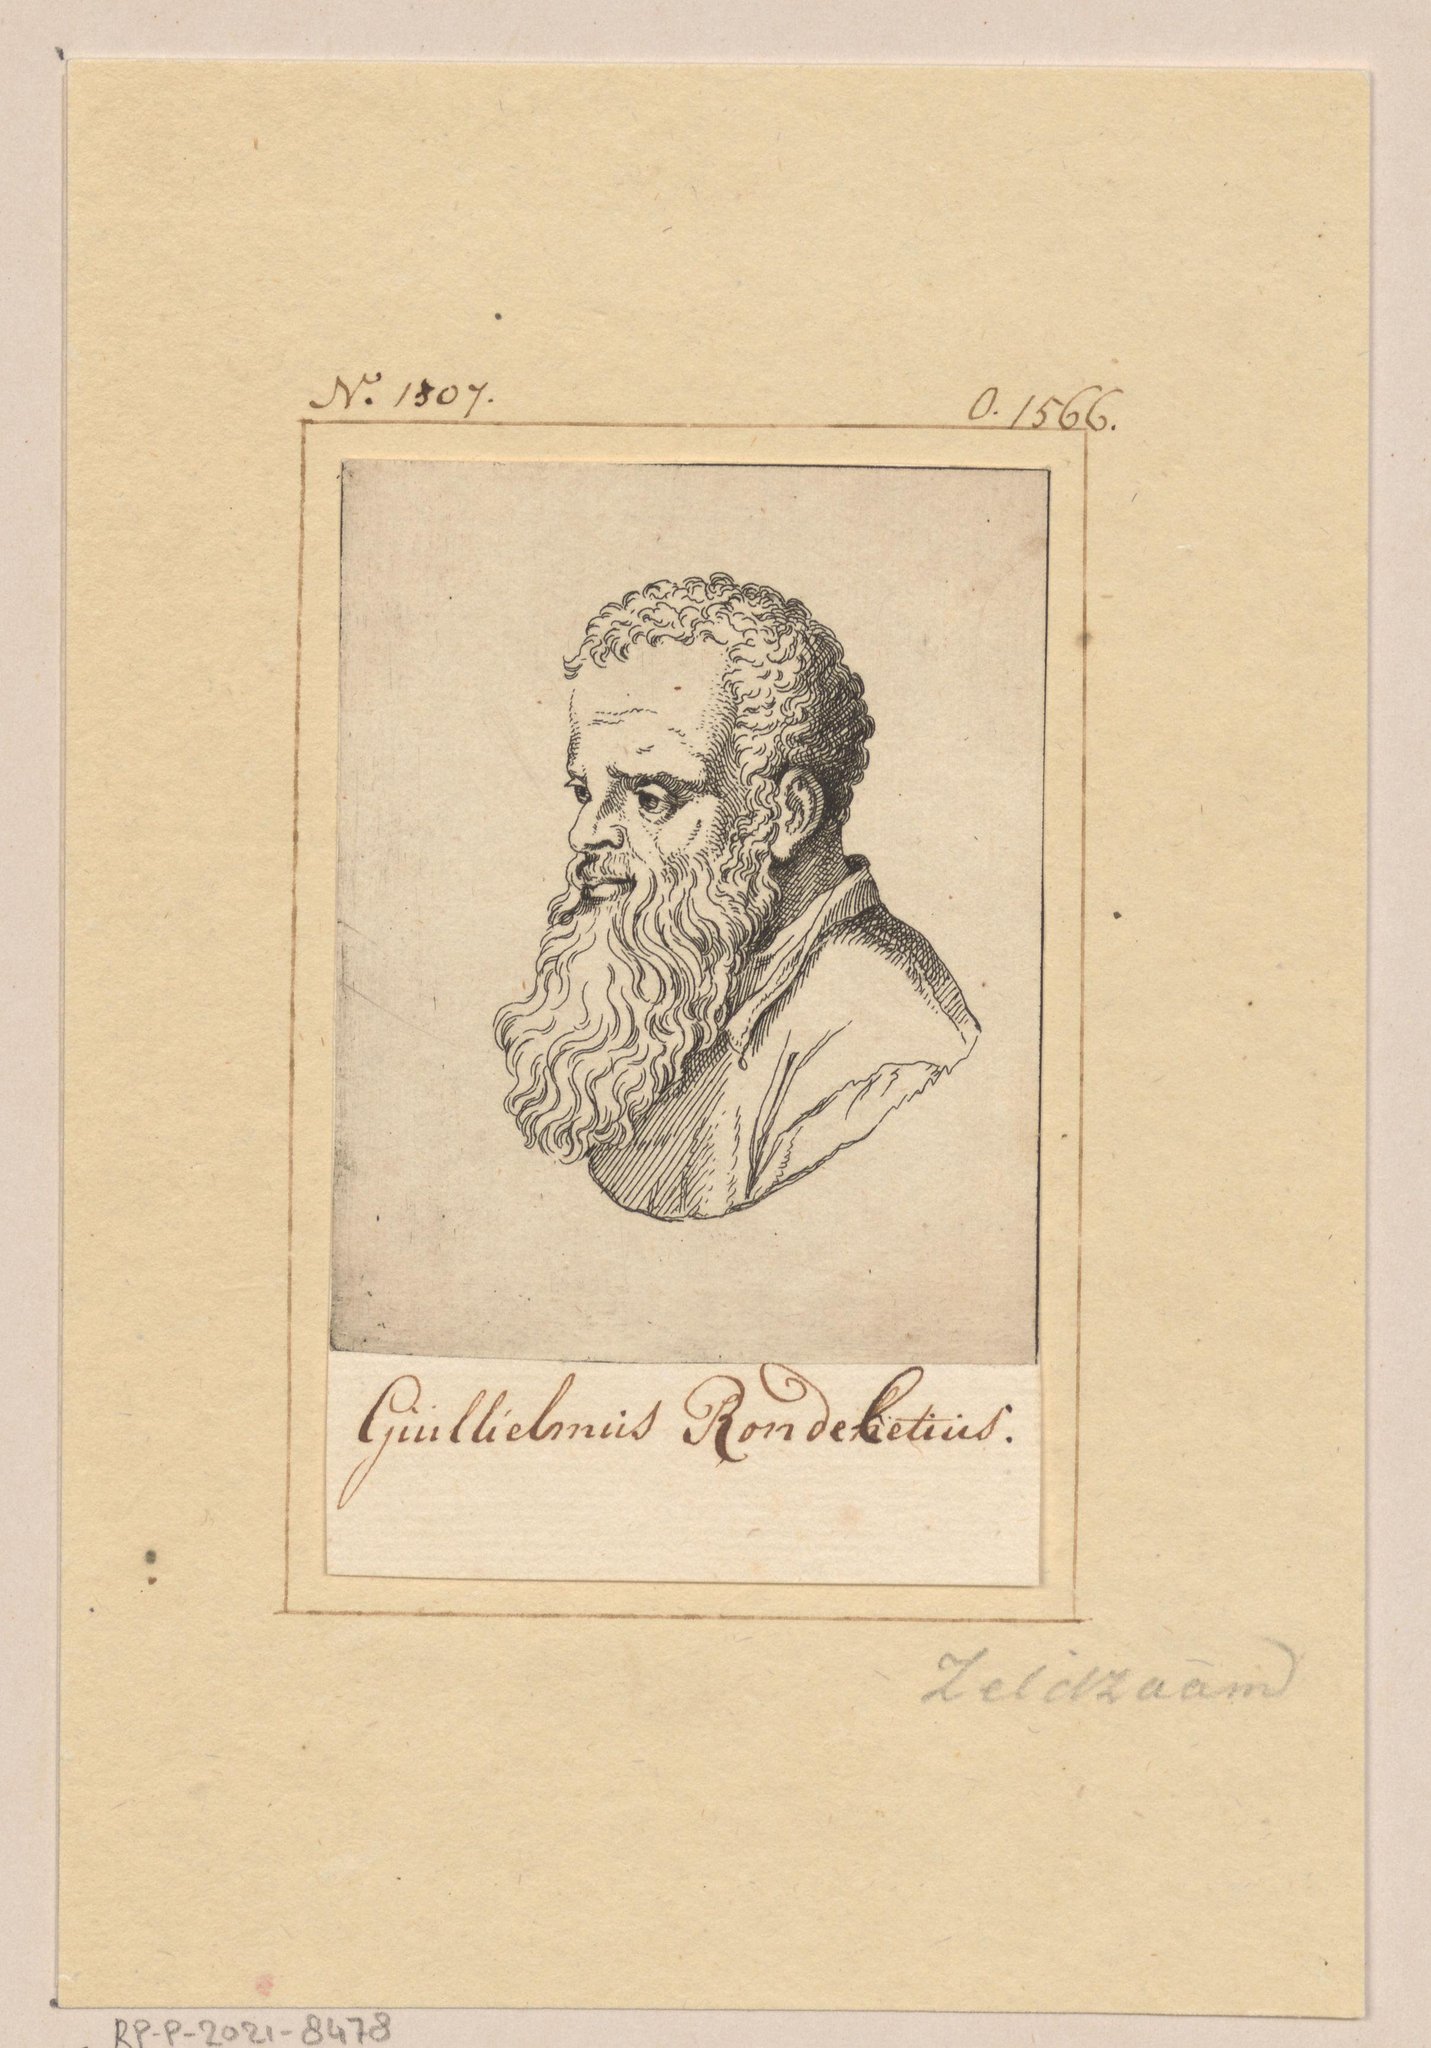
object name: print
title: Portret van Guillaume Rondelet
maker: Anonymous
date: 1700-1799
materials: paper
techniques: etching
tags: physicist, historical persons